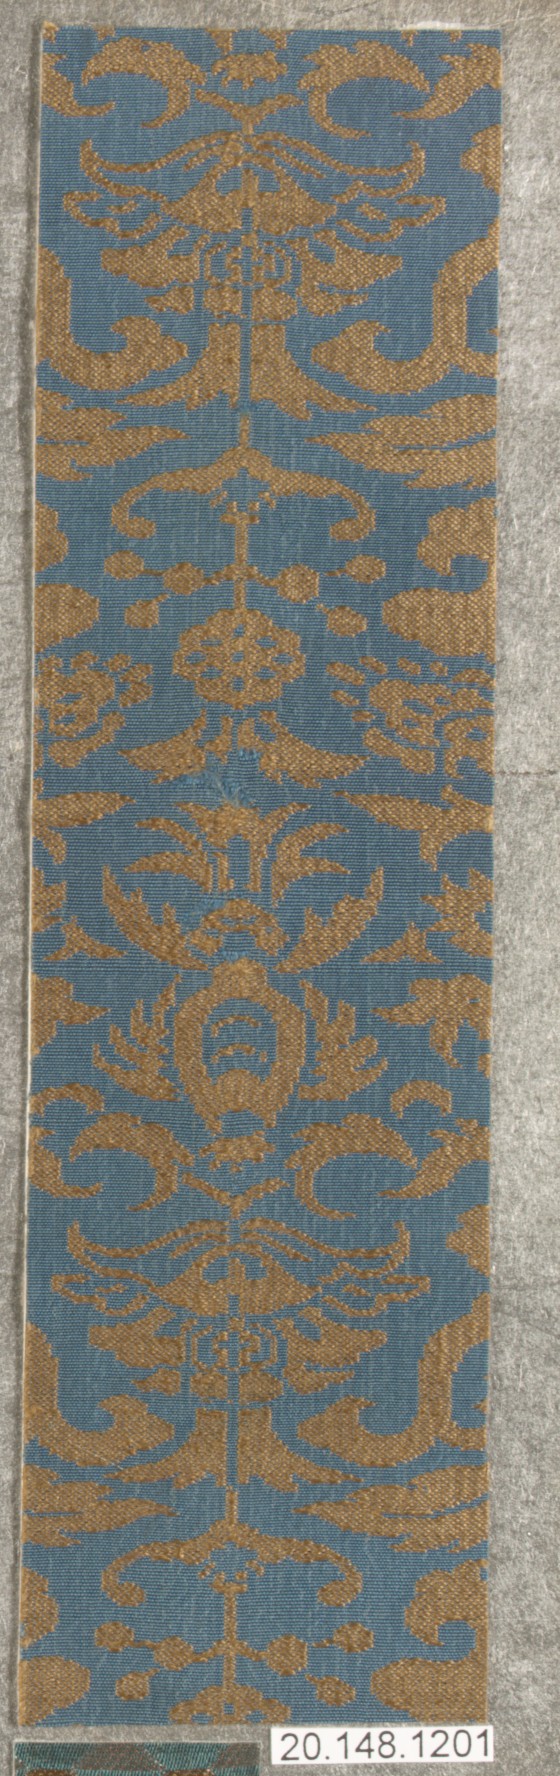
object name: piece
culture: japanese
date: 1701-1800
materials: silk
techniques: compound weave